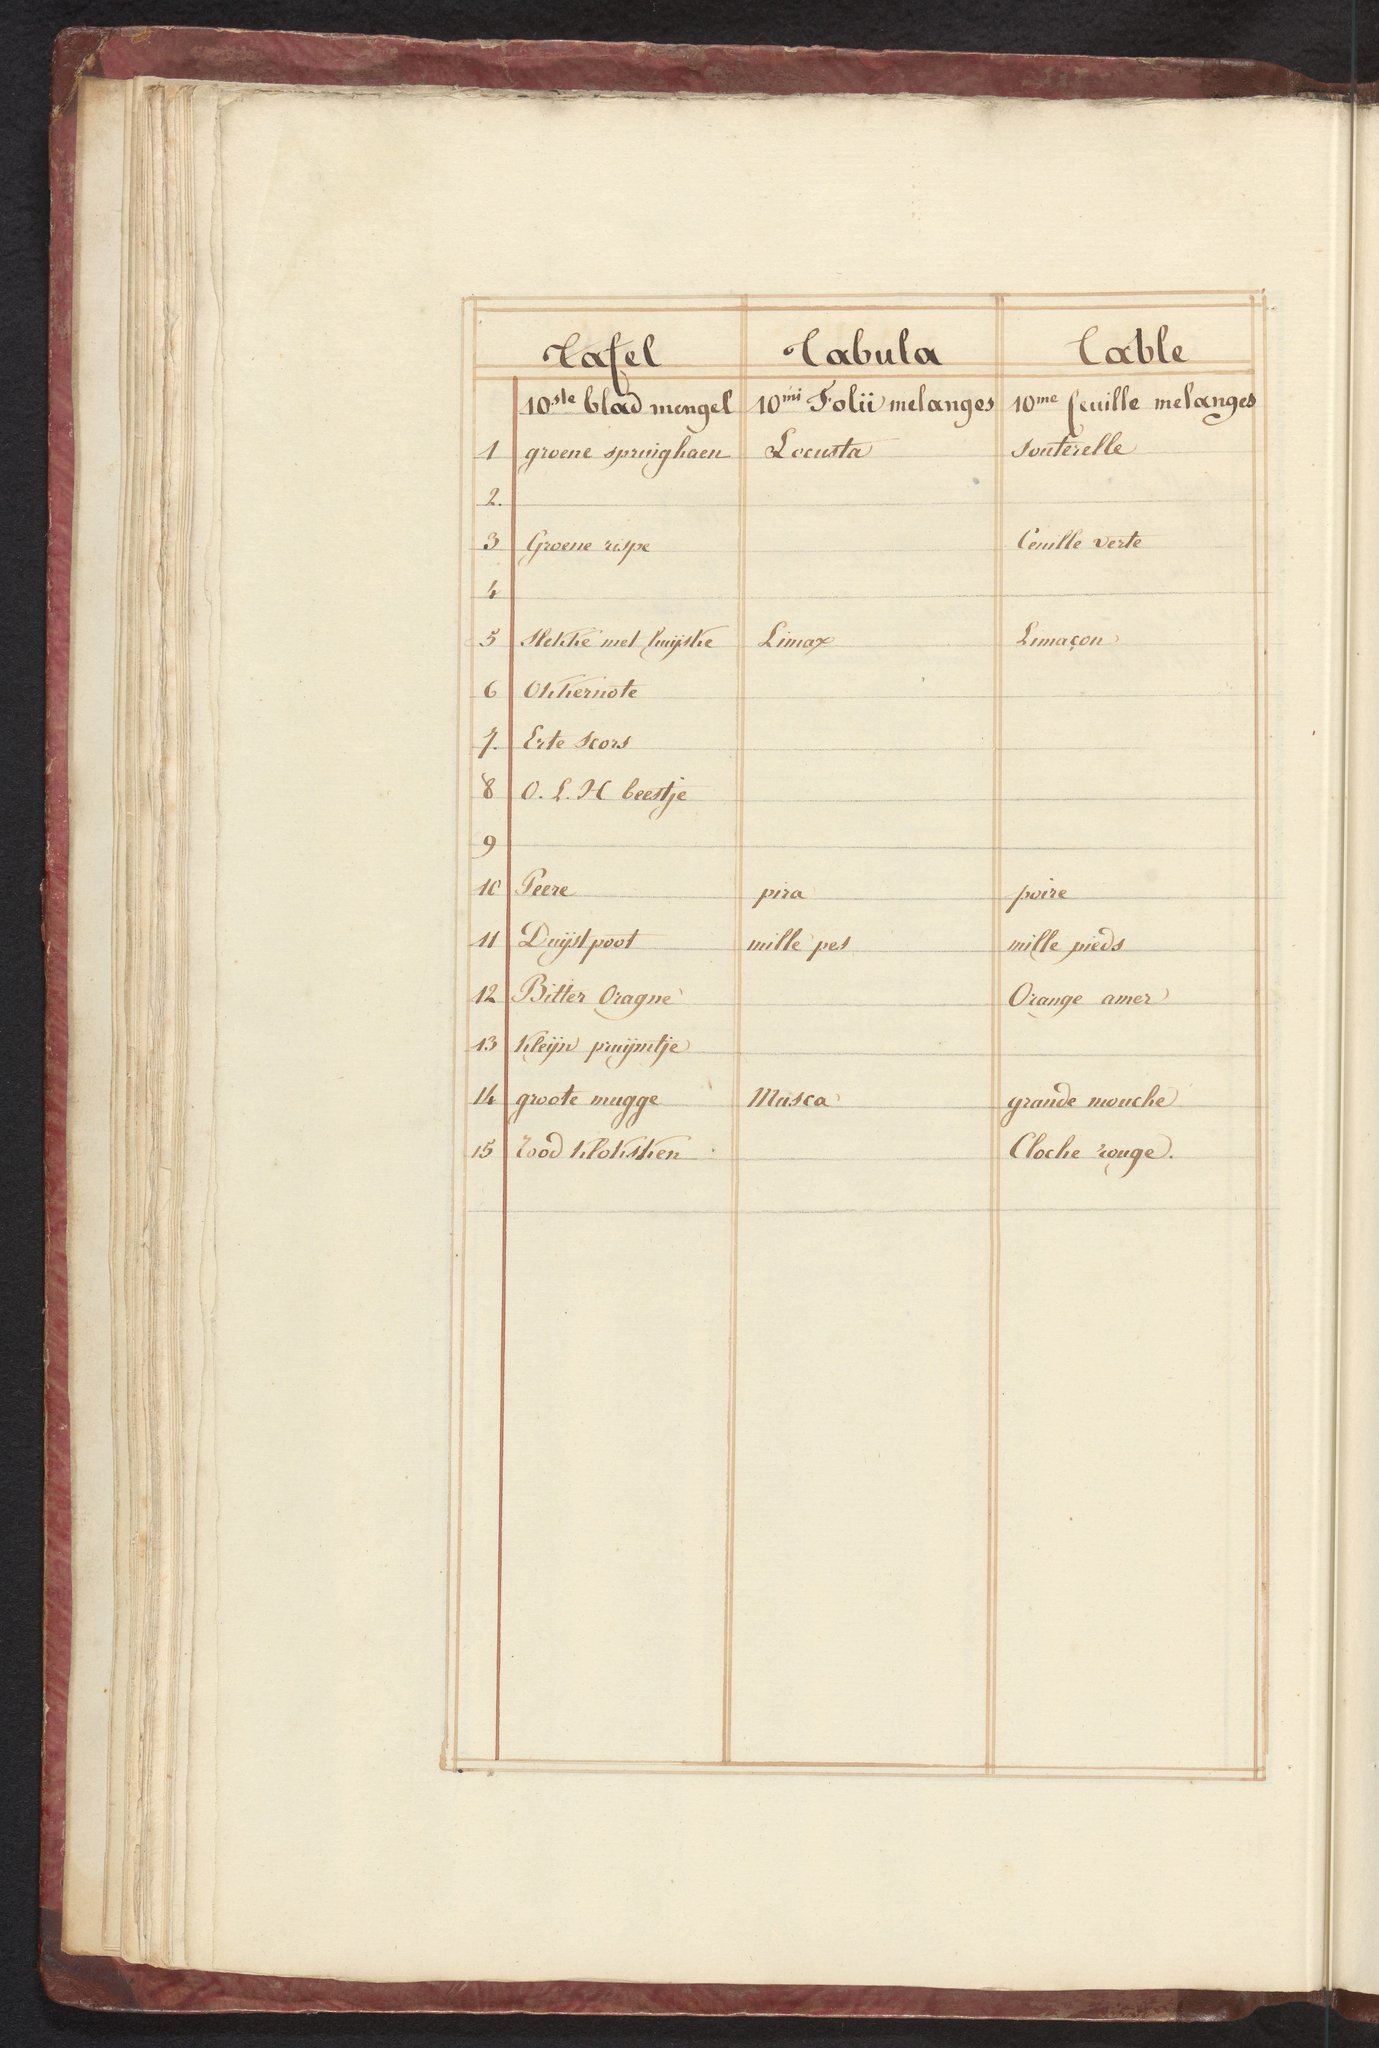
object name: manuscript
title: Tafel 10ste blad mengel. / Tabula 10mi Folii melanges / Table 10me feuille melanges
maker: joseph van huerne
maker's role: kunstliefhebber, mecenas, verzamelaar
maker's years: 1752-1844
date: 1809-1814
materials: ink, paper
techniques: handwriting, pen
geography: bruges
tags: handwriting, written text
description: Schema met een lijst in drie kolommen van de dieren en planten afgebeeld in het tiende ensemble, nummers 1-15. Onderdeel van het zevende album met tekeningen van reptielen, amfibieën en natuurhistorische ensembles. Het zevende van twaalf albums met aquarellen van dieren, vogels en planten bekend rond 1600, gemaakt in opdracht van keizer Rudolf II. Met toelichting in Nederlands, Latijn en Frans.